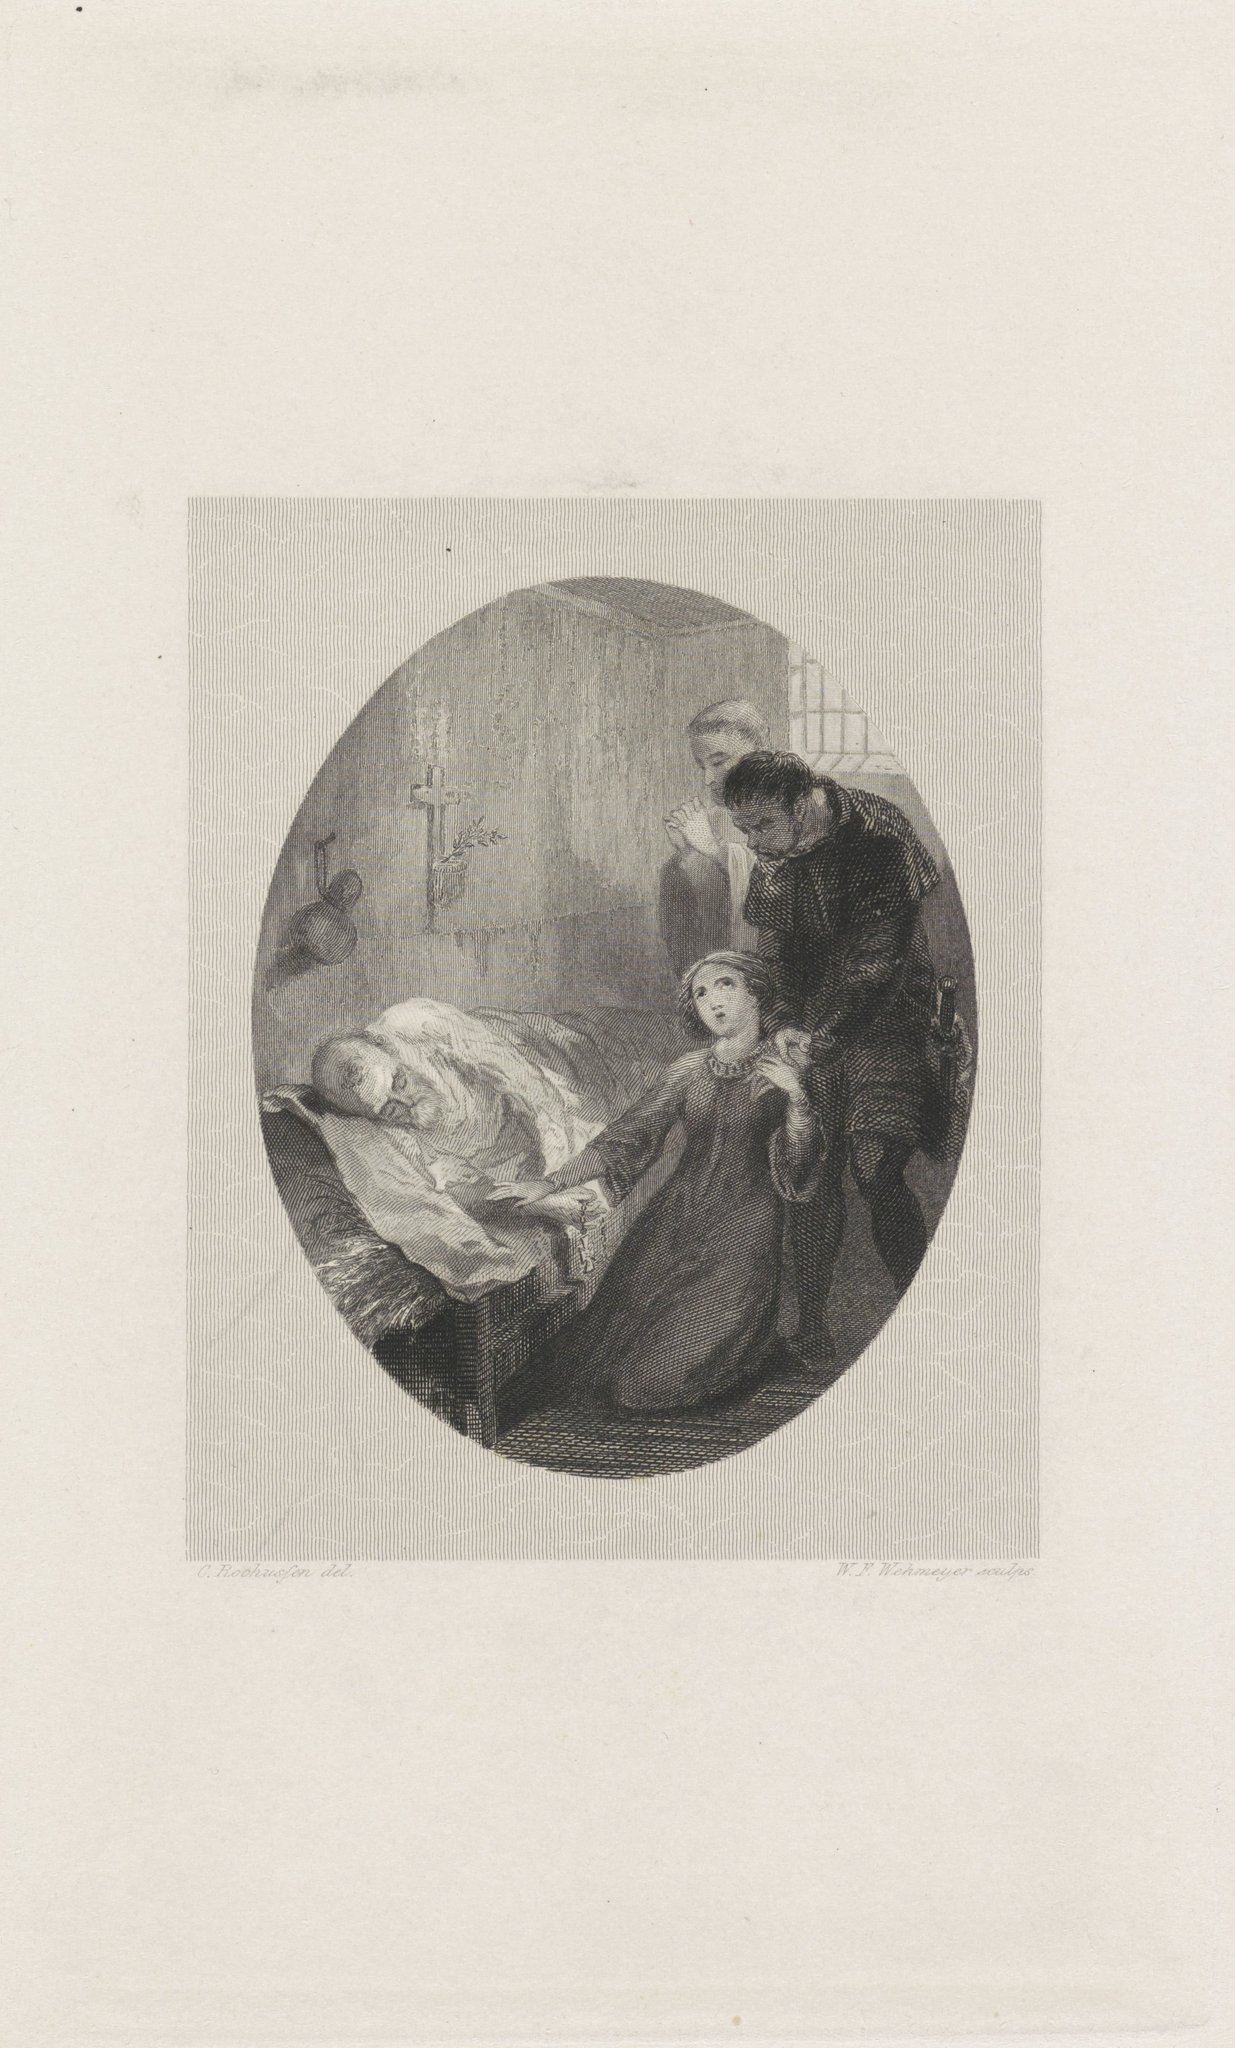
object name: print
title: Figuren aan een sterfbed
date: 1834-1854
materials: paper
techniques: engraving, etching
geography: amsterdam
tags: adolescent, young woman, maiden, aids for prayer, e.g. rosary, private soldier, deathbed, regular clerics, e.g. jesuits, redemptorists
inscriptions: collector's mark: Lugt 2228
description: Een geestelijke en een soldaat staan aan het sterfbed van een oude man. Bij het bed knielt een jonge vrouw. De oude man houdt een rozenkrans vast. Aan de wand hangt een kruis met een palmtakje en een wijwaterbakje.